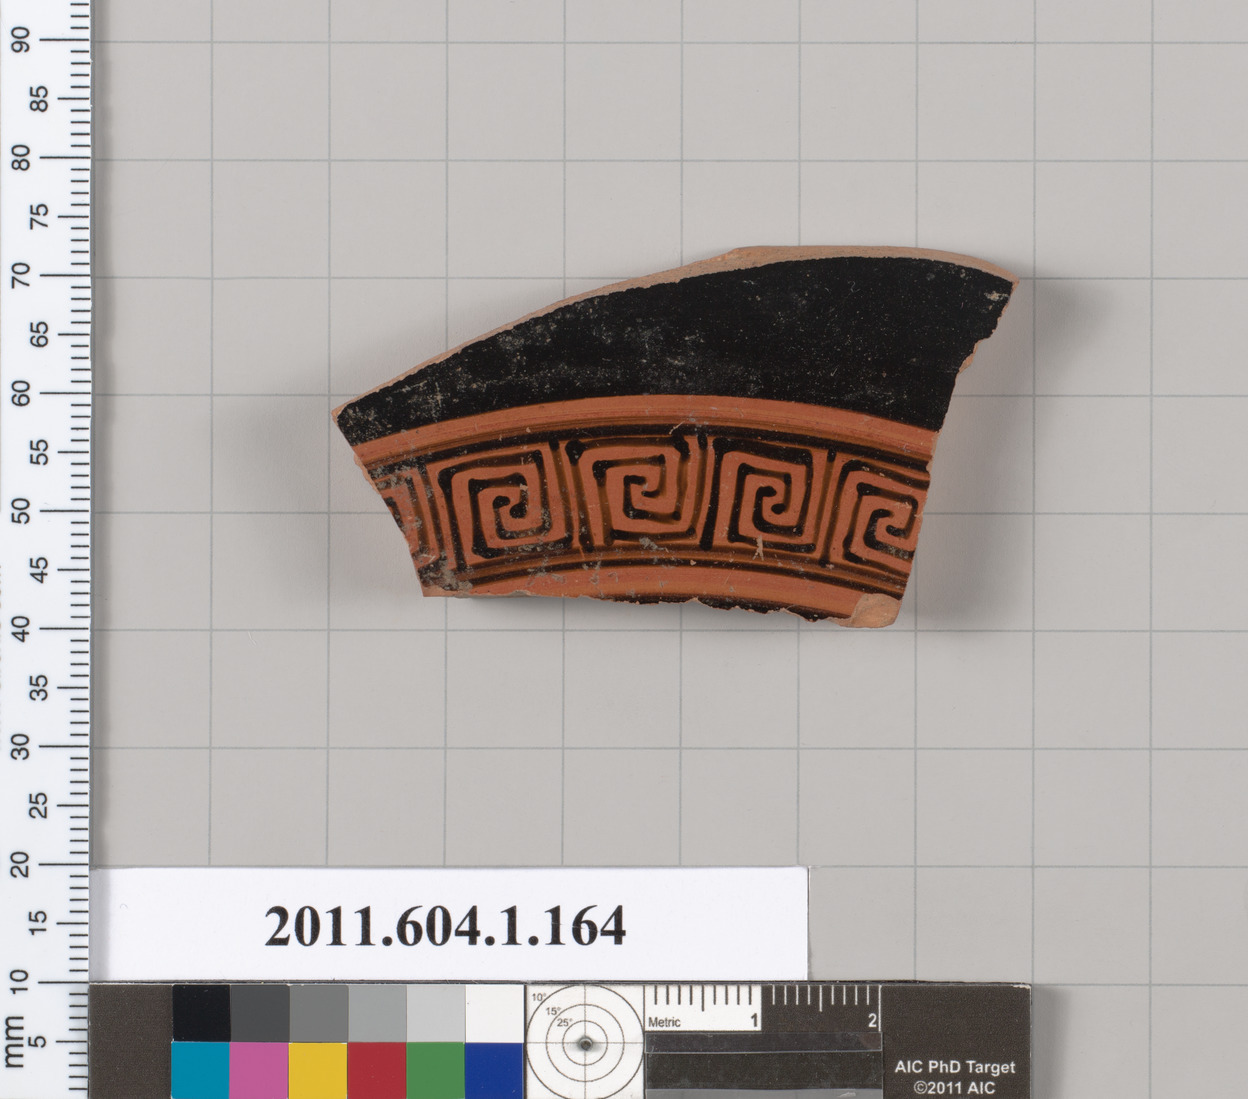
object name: kylix fragment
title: Terracotta fragment of a kylix (drinking cup)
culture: greek, attic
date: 470-450 BCE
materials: terracotta